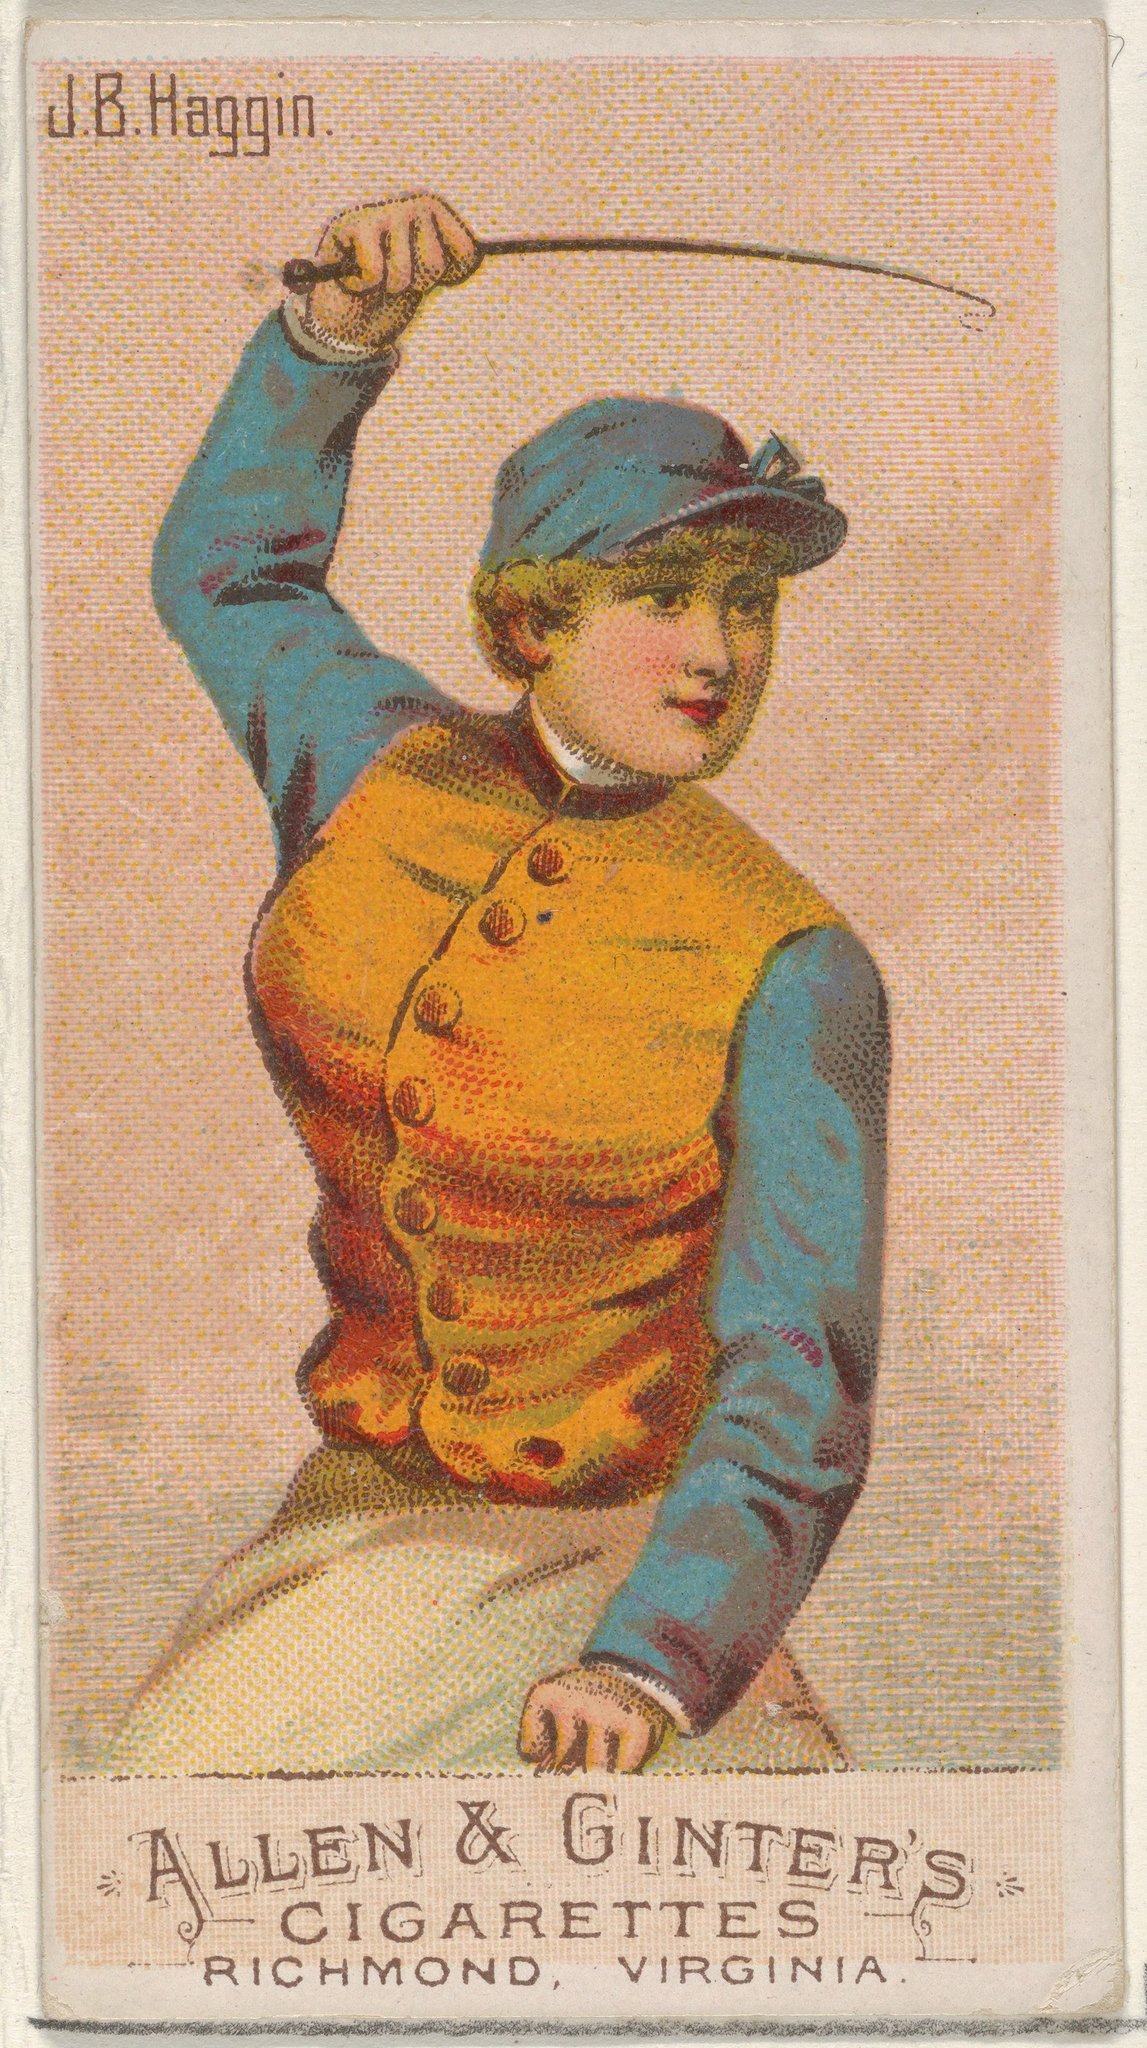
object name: print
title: J.B. Haggin, from the Racing Colors of the World series (N22a) for Allen & Ginter Cigarettes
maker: allen & ginter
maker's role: publisher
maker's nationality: american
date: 1888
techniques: color lithograph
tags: women,jockeys